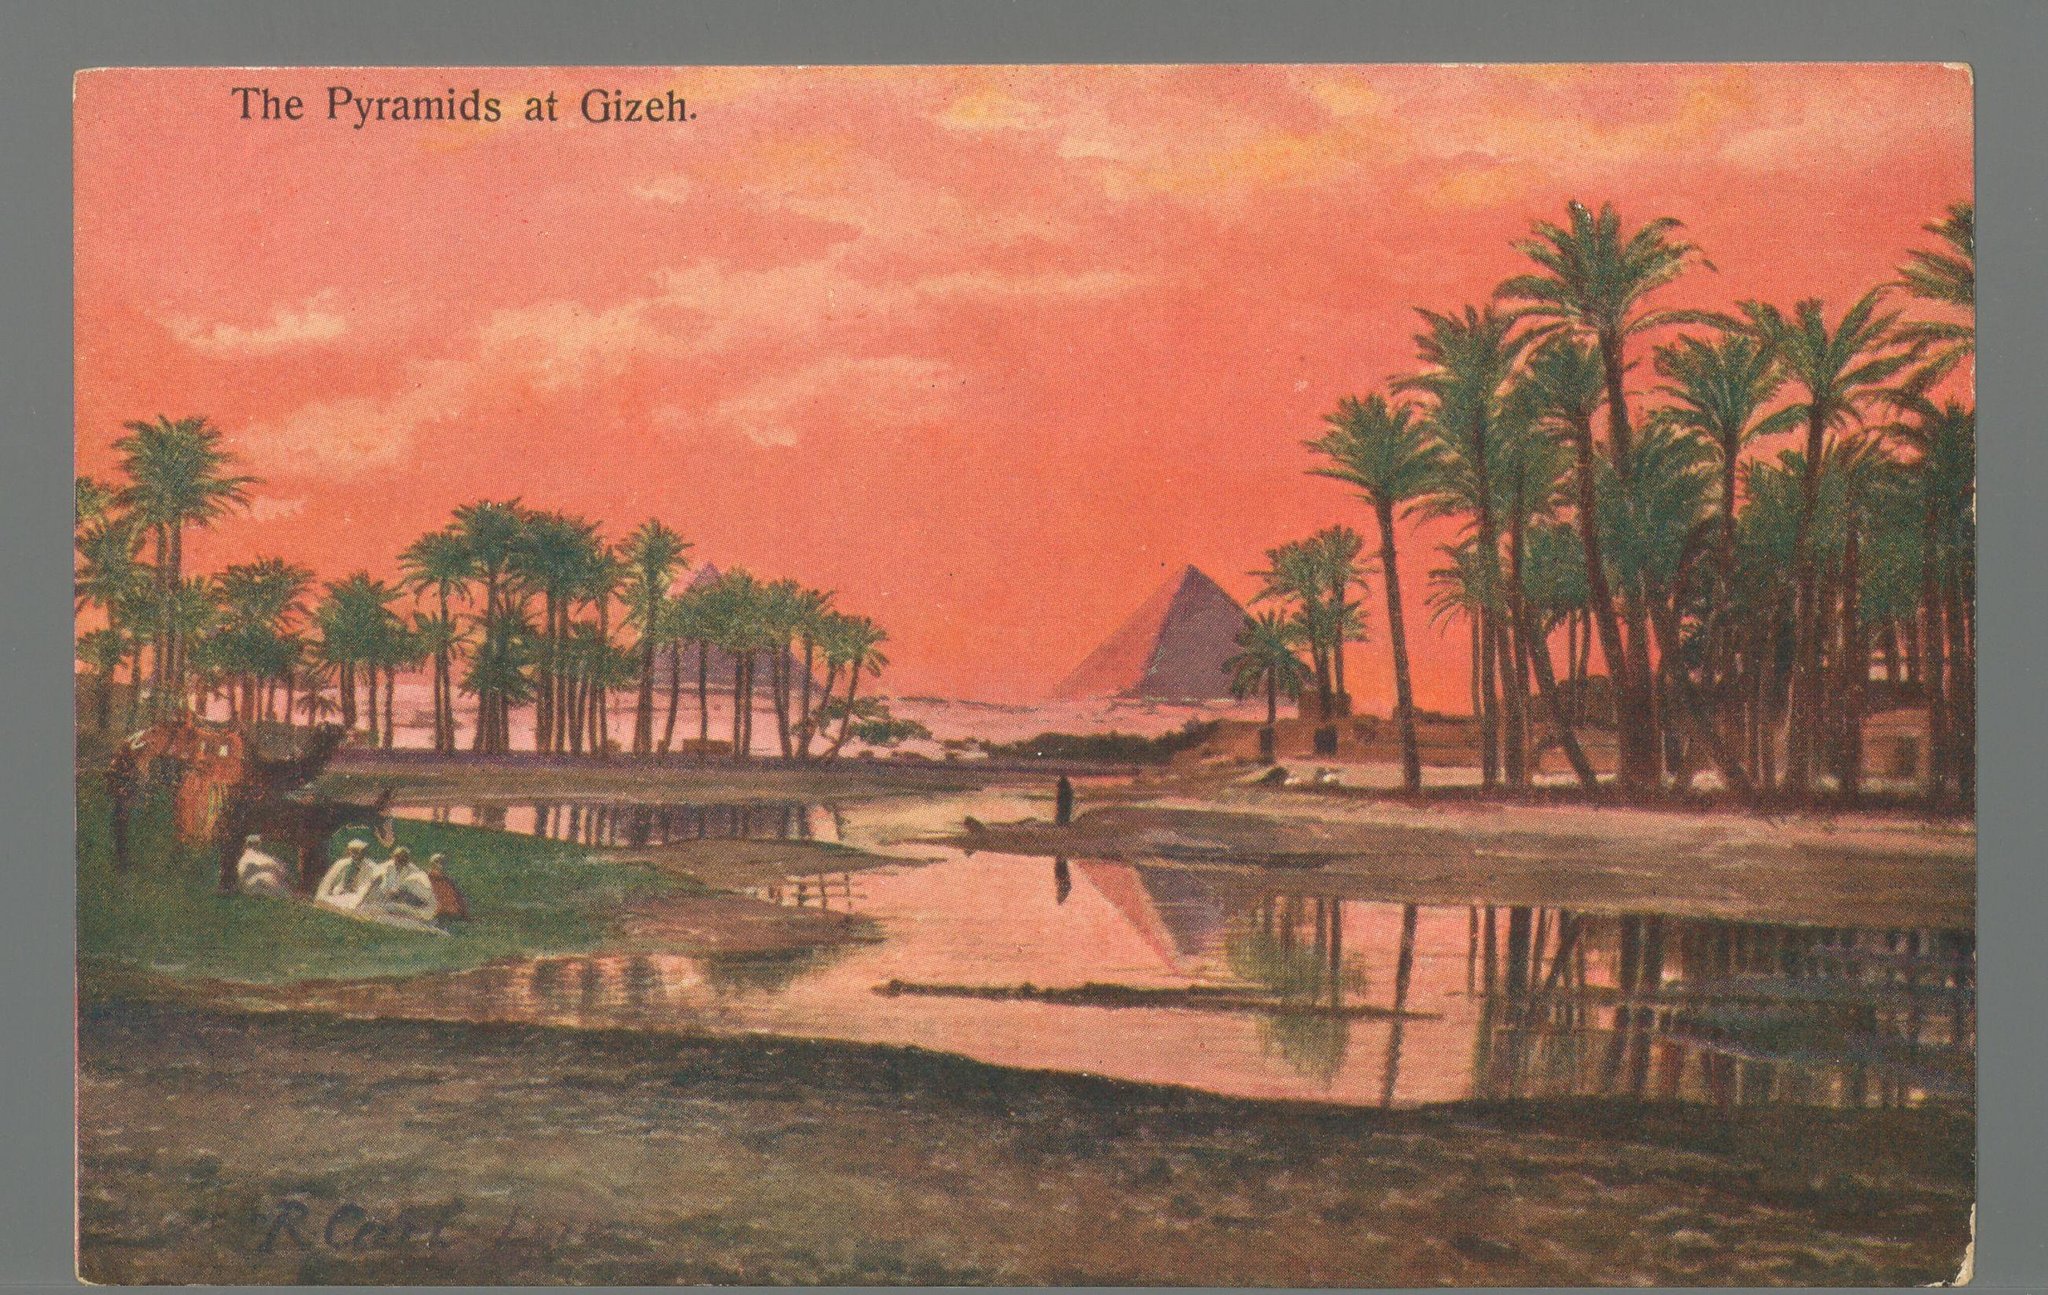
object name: reproduction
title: The Pyramids at Gizeh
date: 1905-1930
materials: cardboard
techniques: color autotype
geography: cairo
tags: river, quadrangular pyramid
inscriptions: inscription: ‘R. Carl L’